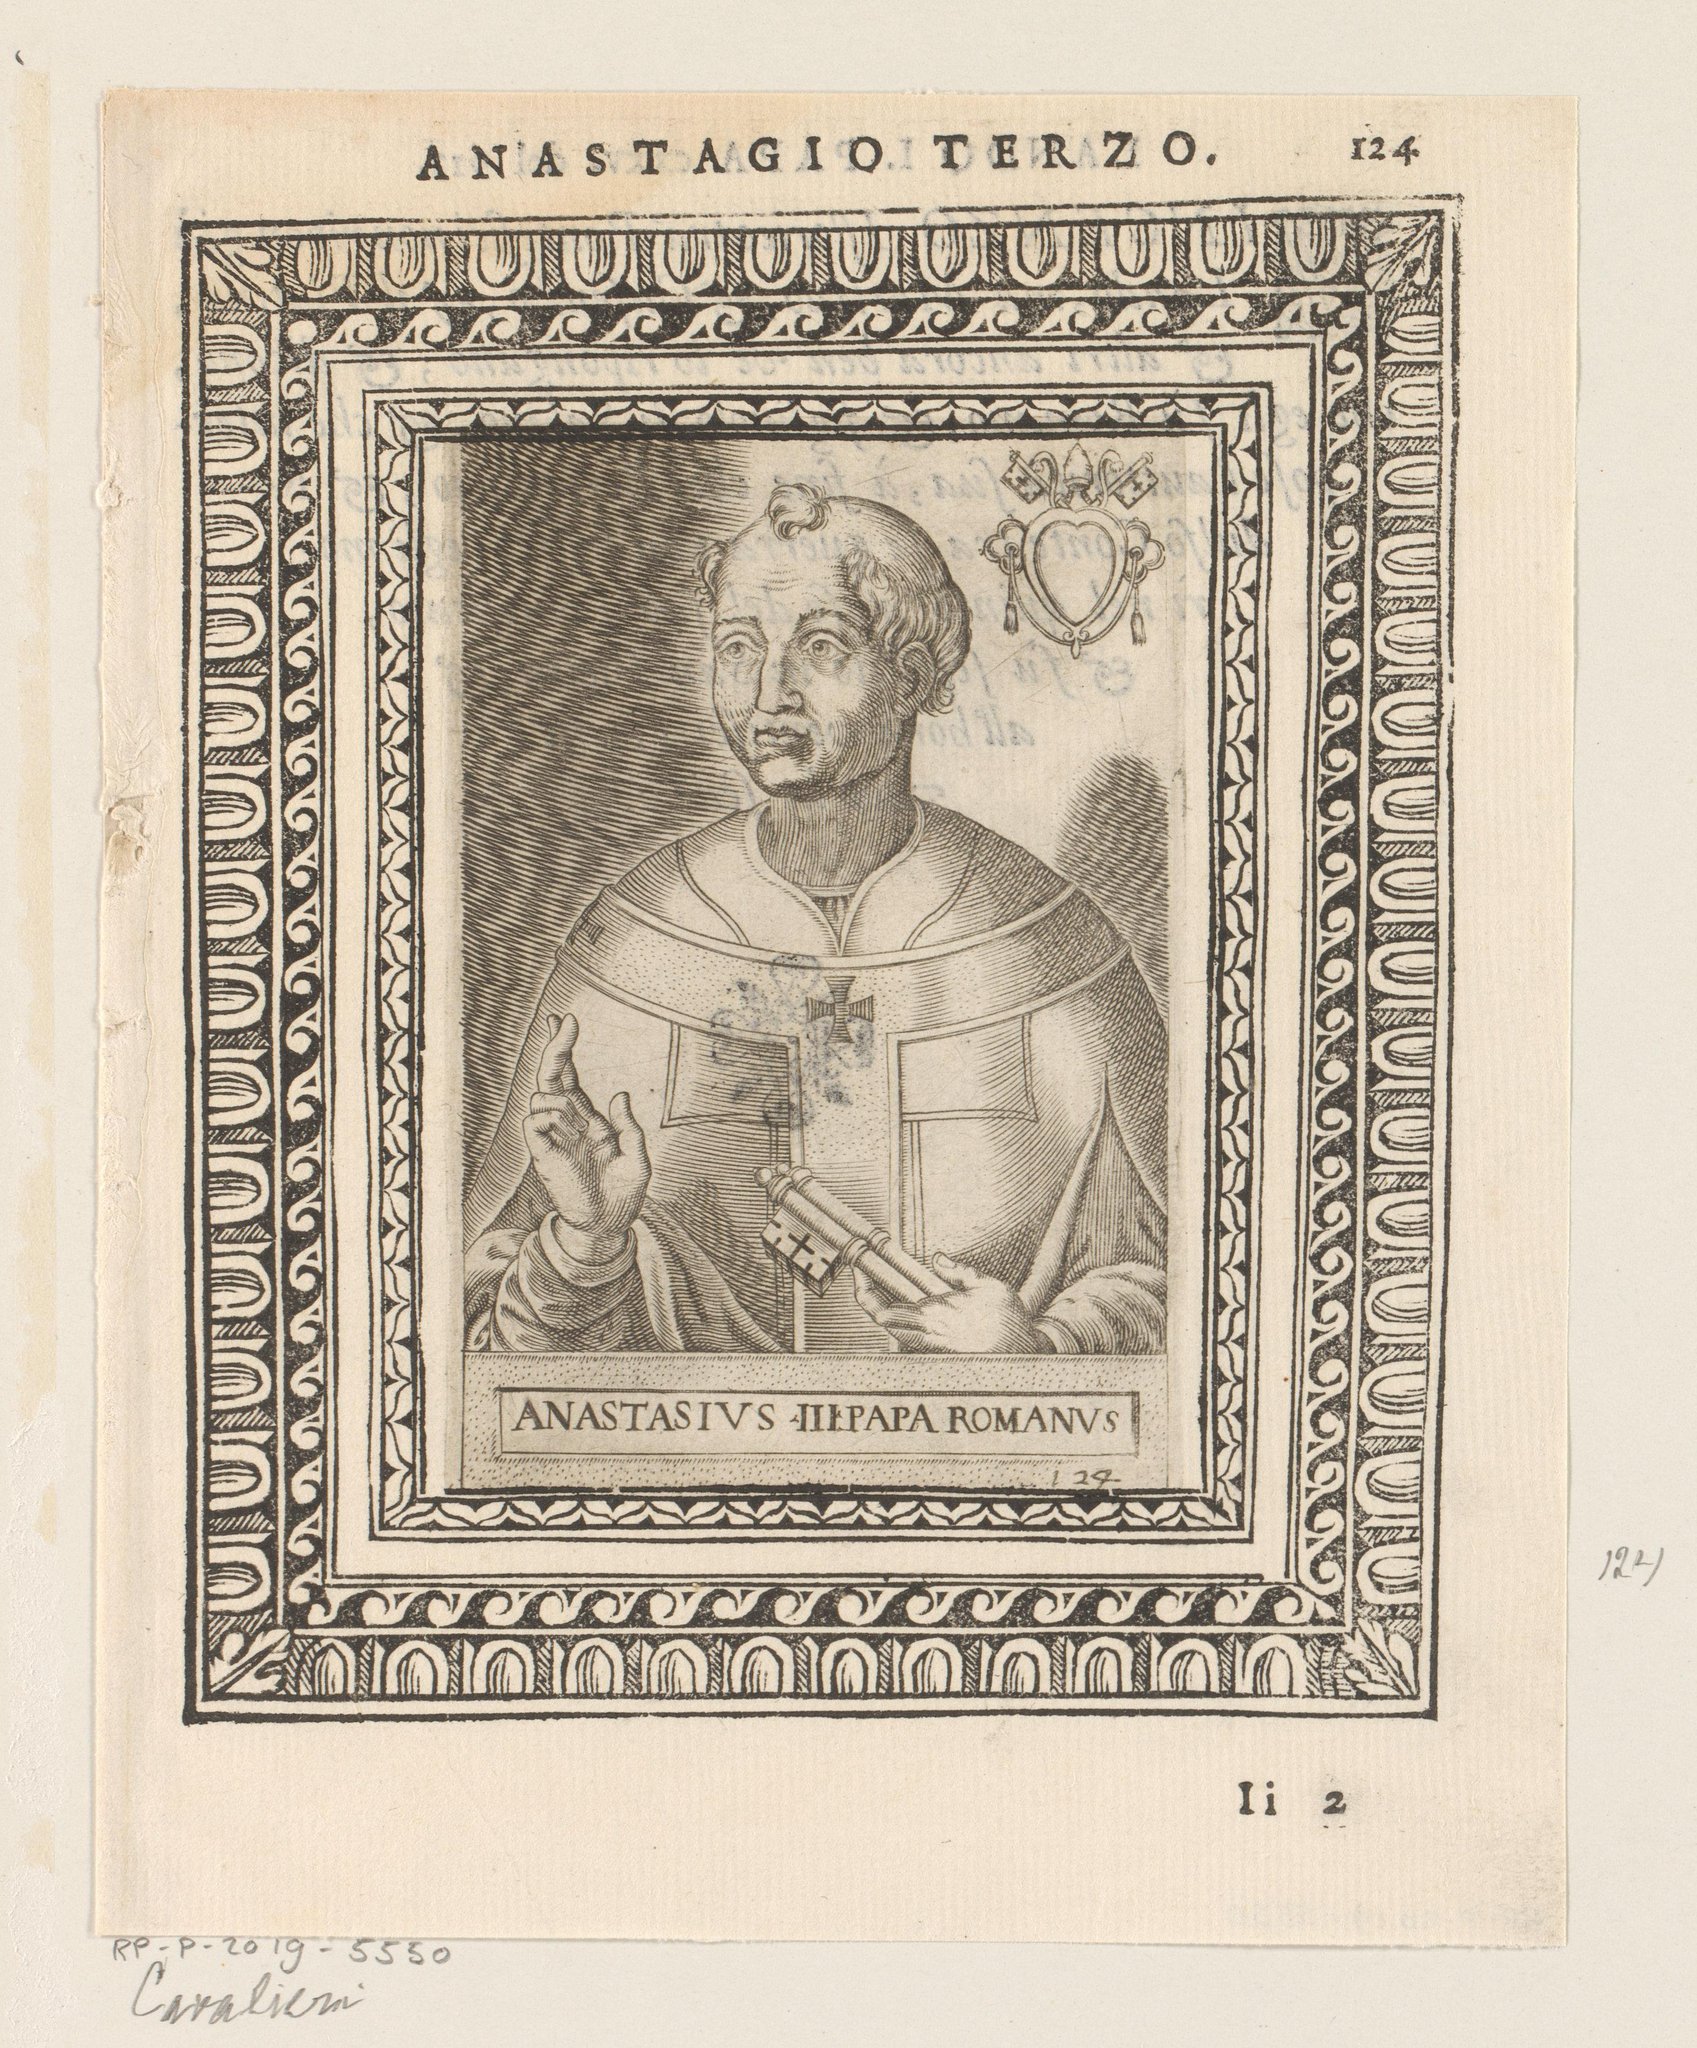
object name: print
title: Anastasius III Papa Romanus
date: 1587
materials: paper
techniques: engraving, letterpress printing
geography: rome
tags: rome, historical persons, pope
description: Prent uit: Ciccarelli, Antonio. Le vite de Pontefici di Antonio Ciccarelli (...). Rome: Domenico Basa, 1587. Prent voor het eerst verschenen in: Cavalieri, Giovanni Battista de'. Pontificum romanorum effigies (...). Rome: Domenico Basa en Francesco Zanetti, 1580. Prent ook gebruikt in latere publicaties.